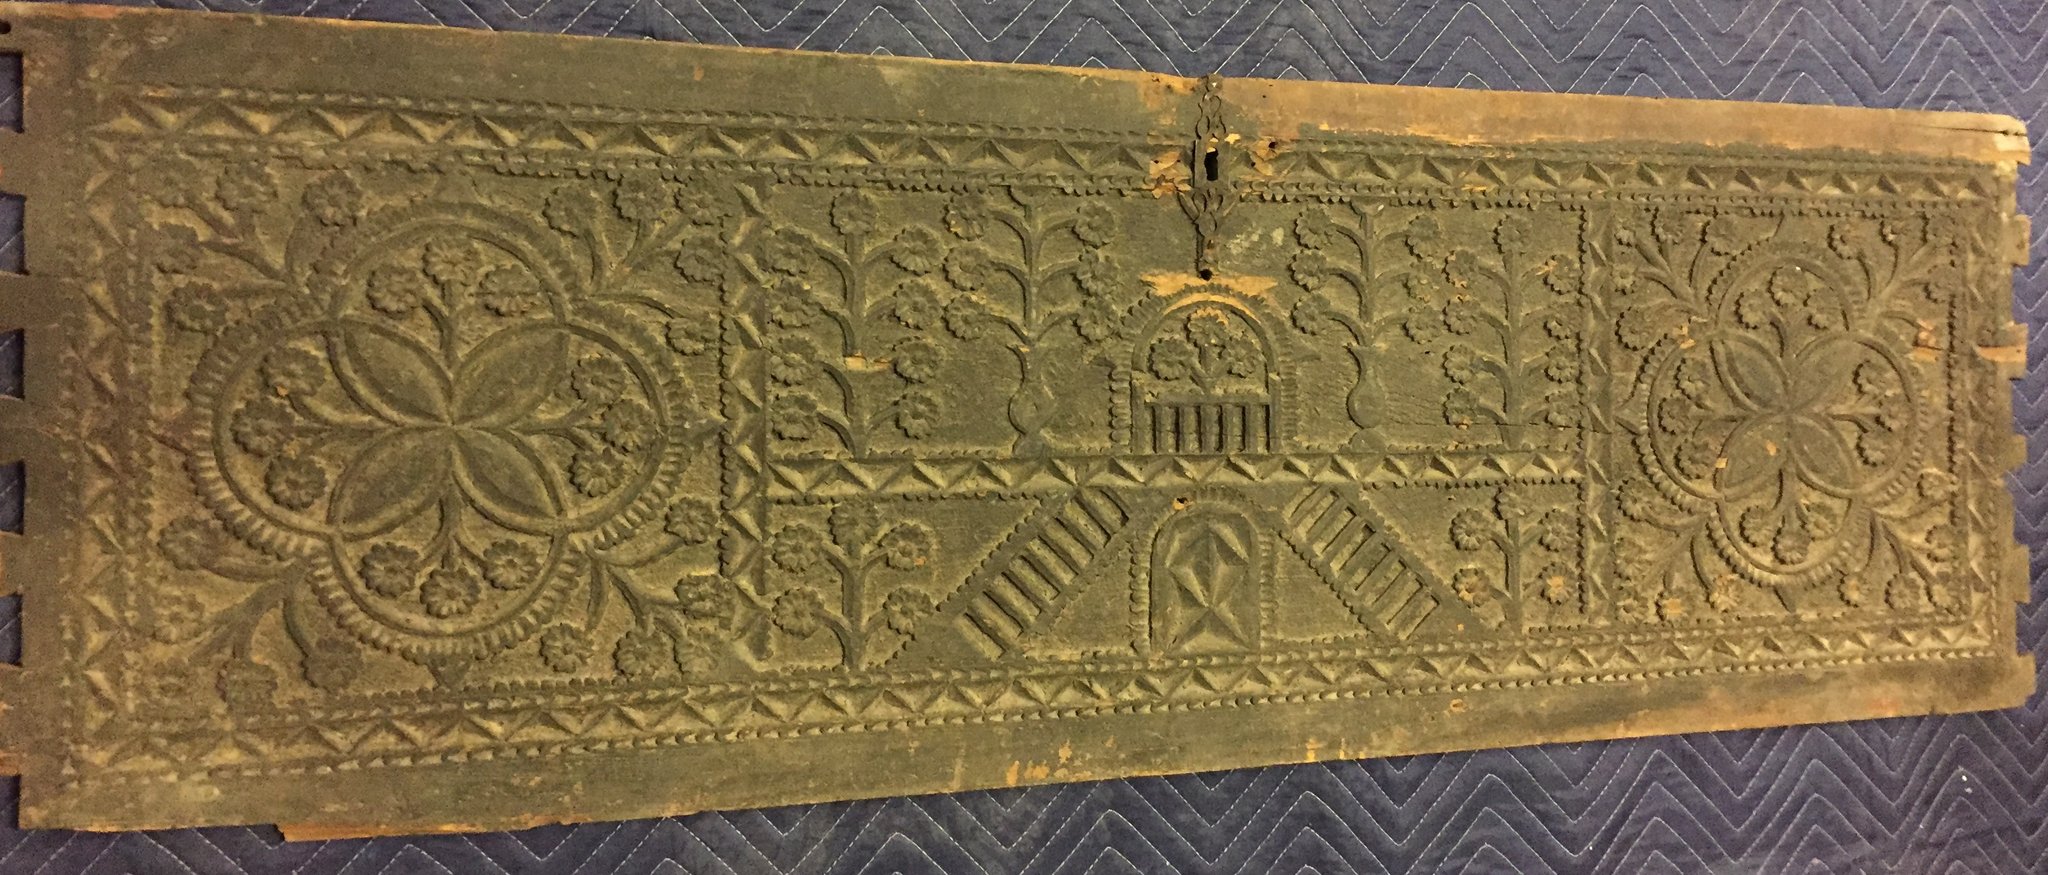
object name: chest front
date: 1701-1800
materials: wood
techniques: carving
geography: syria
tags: flowers,furniture